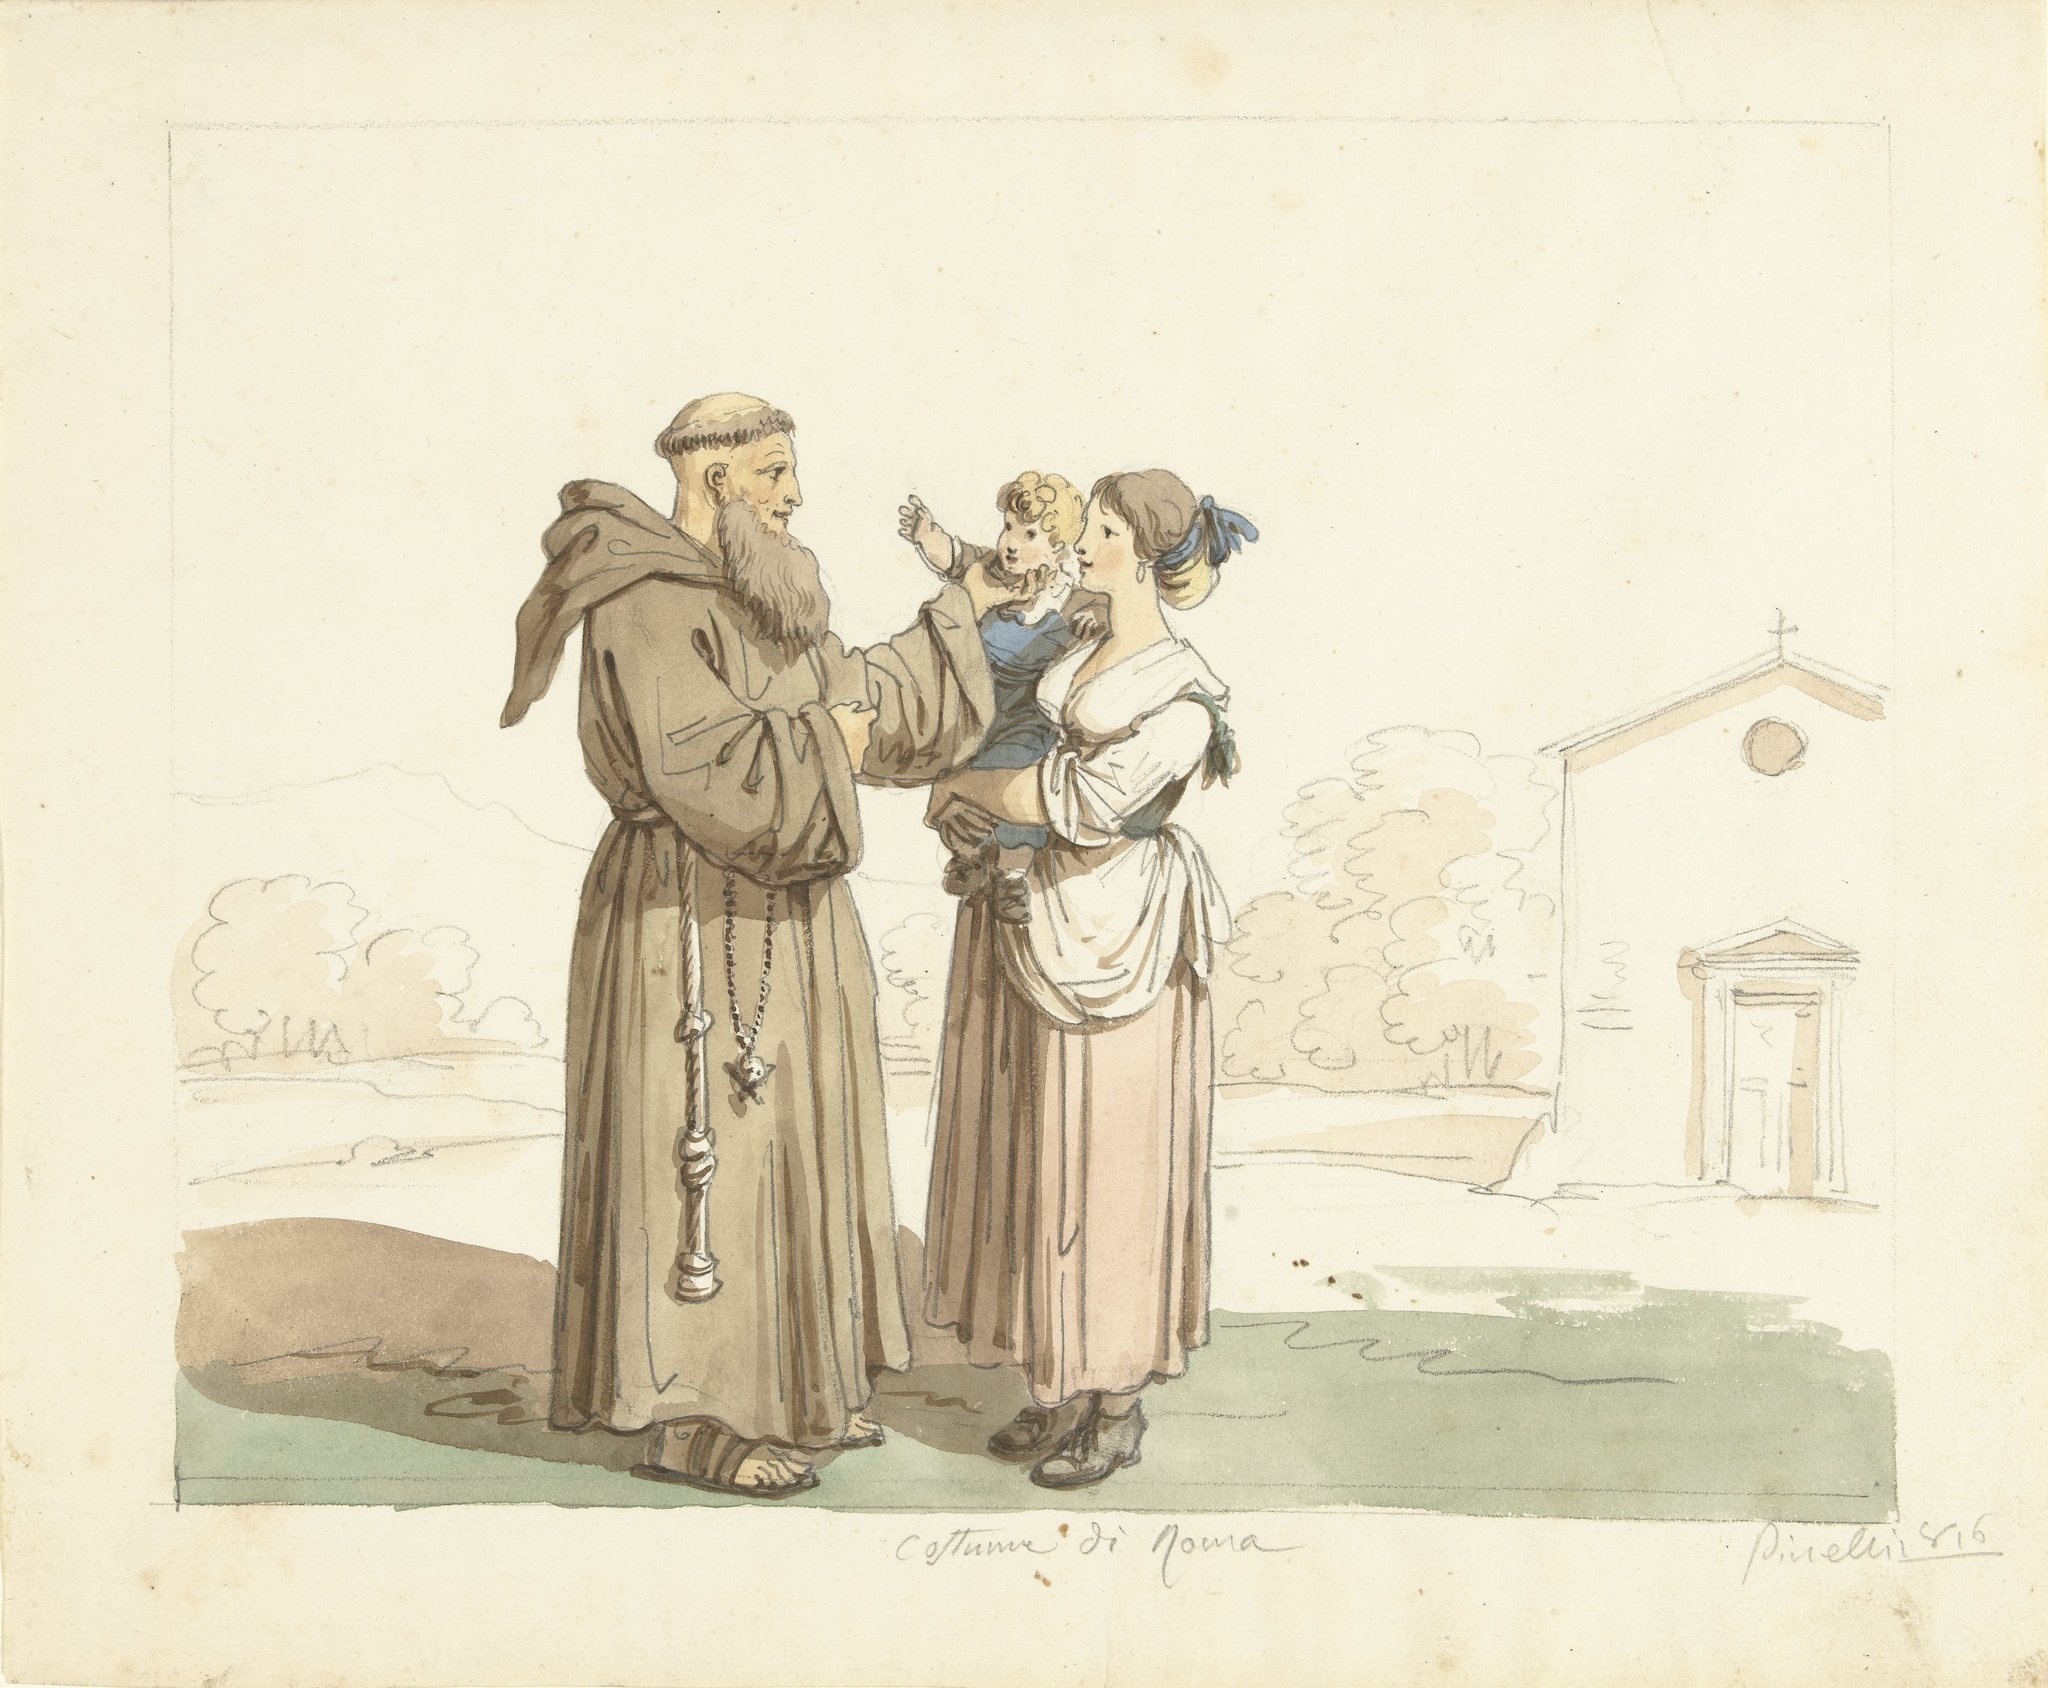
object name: watercolor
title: Jonge vrouw met kind staande voor een monnik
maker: bartolomeo pinelli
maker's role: draughtsman, print maker, sculptor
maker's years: 1781-1835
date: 1816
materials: paper, pencil, watercolor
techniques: brush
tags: monk(s), friar(s), mother and baby or young child, folk costume, regional costume, europeans (with name) (+ costume), rome